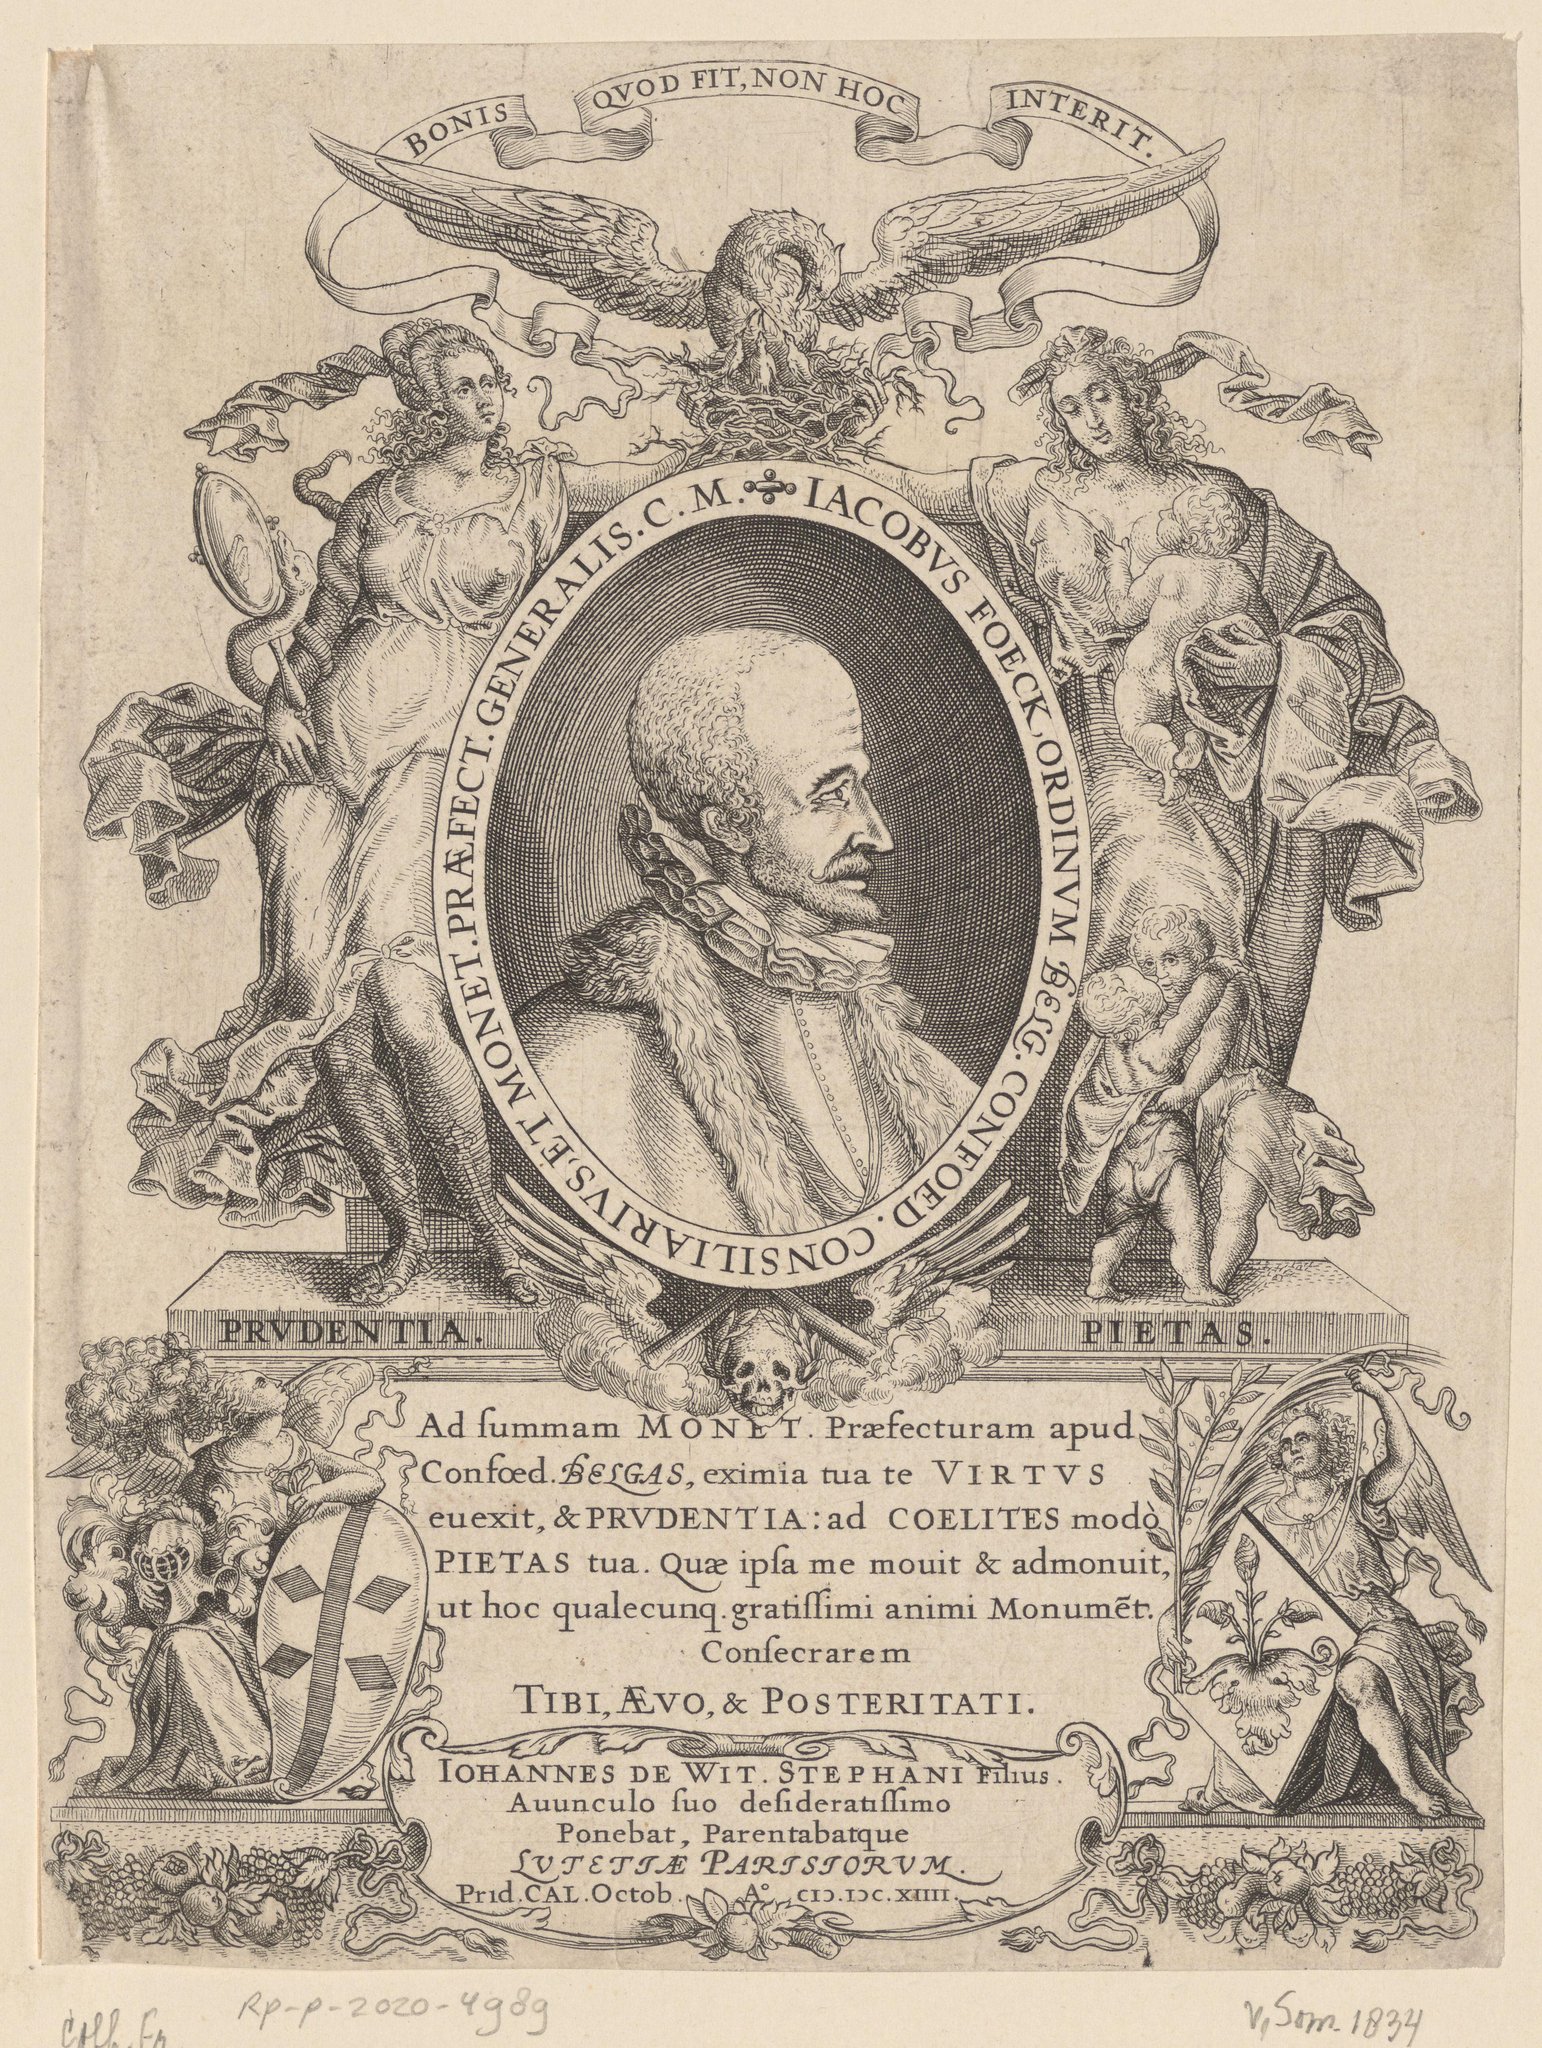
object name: print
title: Allegorisch portret van Jacob Foeck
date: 1614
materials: paper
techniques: engraving, etching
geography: france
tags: mintmaster, prudence, 'prudentia'; 'prudenza' (ripa) ~ one of the four cardinal virtues, fruits and vegetables ~ ornament, historical persons, crowning with laurel, piety, 'pietas', 'timor dei' ~ the three theological virtues, angels, fabulous animals ~ birds: phoenix, death's head, skull (symbol of death)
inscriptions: collector's mark: ‘P. mariette 1670’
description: Portret in ovaal, allegorie op zijn overlijden. Boven het portret de spreuk 'bonis quod fit, non hoc interit' met een feniks en drie jongen in een nest. Het nest wordt ondersteund door Voorzichtigheid (Prudentia) en Vroomheid (Pietas) die aan weerszijden van het portret staan. Onder het portret een doodshoofd met lauwerkrans. Op de sokkel een onderschrift in het Latijn. Aan weerszijden van het onderschrift zitten twee engelen.